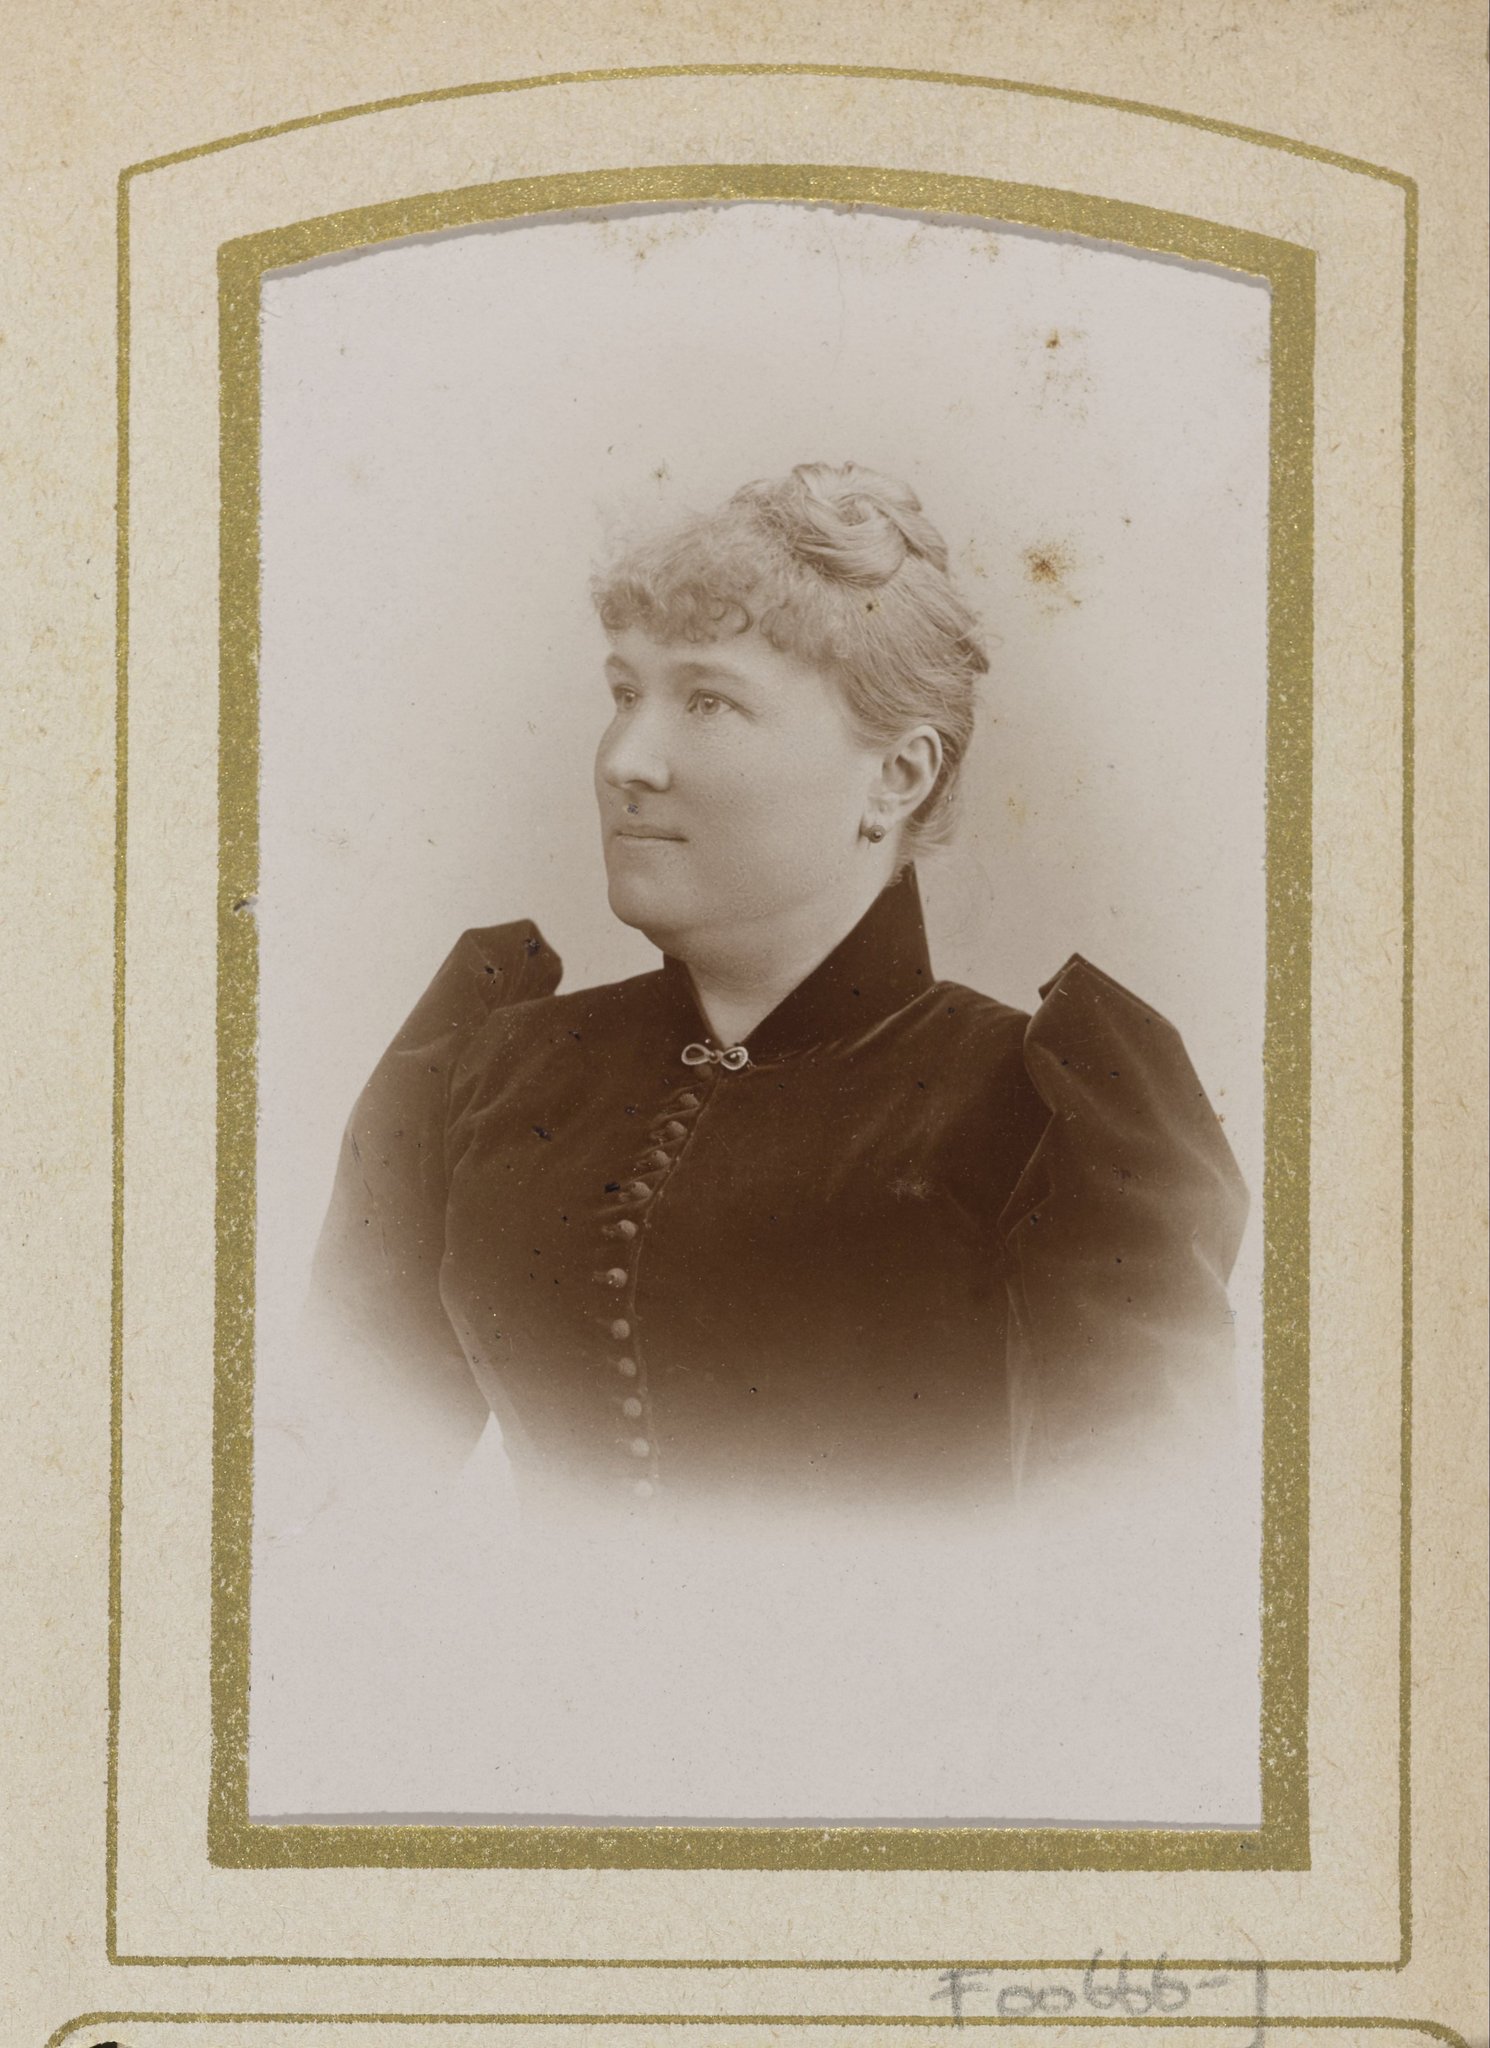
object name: photograph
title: Portret van een vrouw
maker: adolphe zimmermans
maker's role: fotograaf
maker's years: 1858-1922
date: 1879-1913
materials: cardboard, photographic support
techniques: collodion silver print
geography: the hague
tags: historical persons - bb - woman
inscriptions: inscription: ‘Adolphe Zimmermans/ de Riemerstraat 21,/ La Haye./ Specialité pour les agrandissements/ au charbon inalterable.’